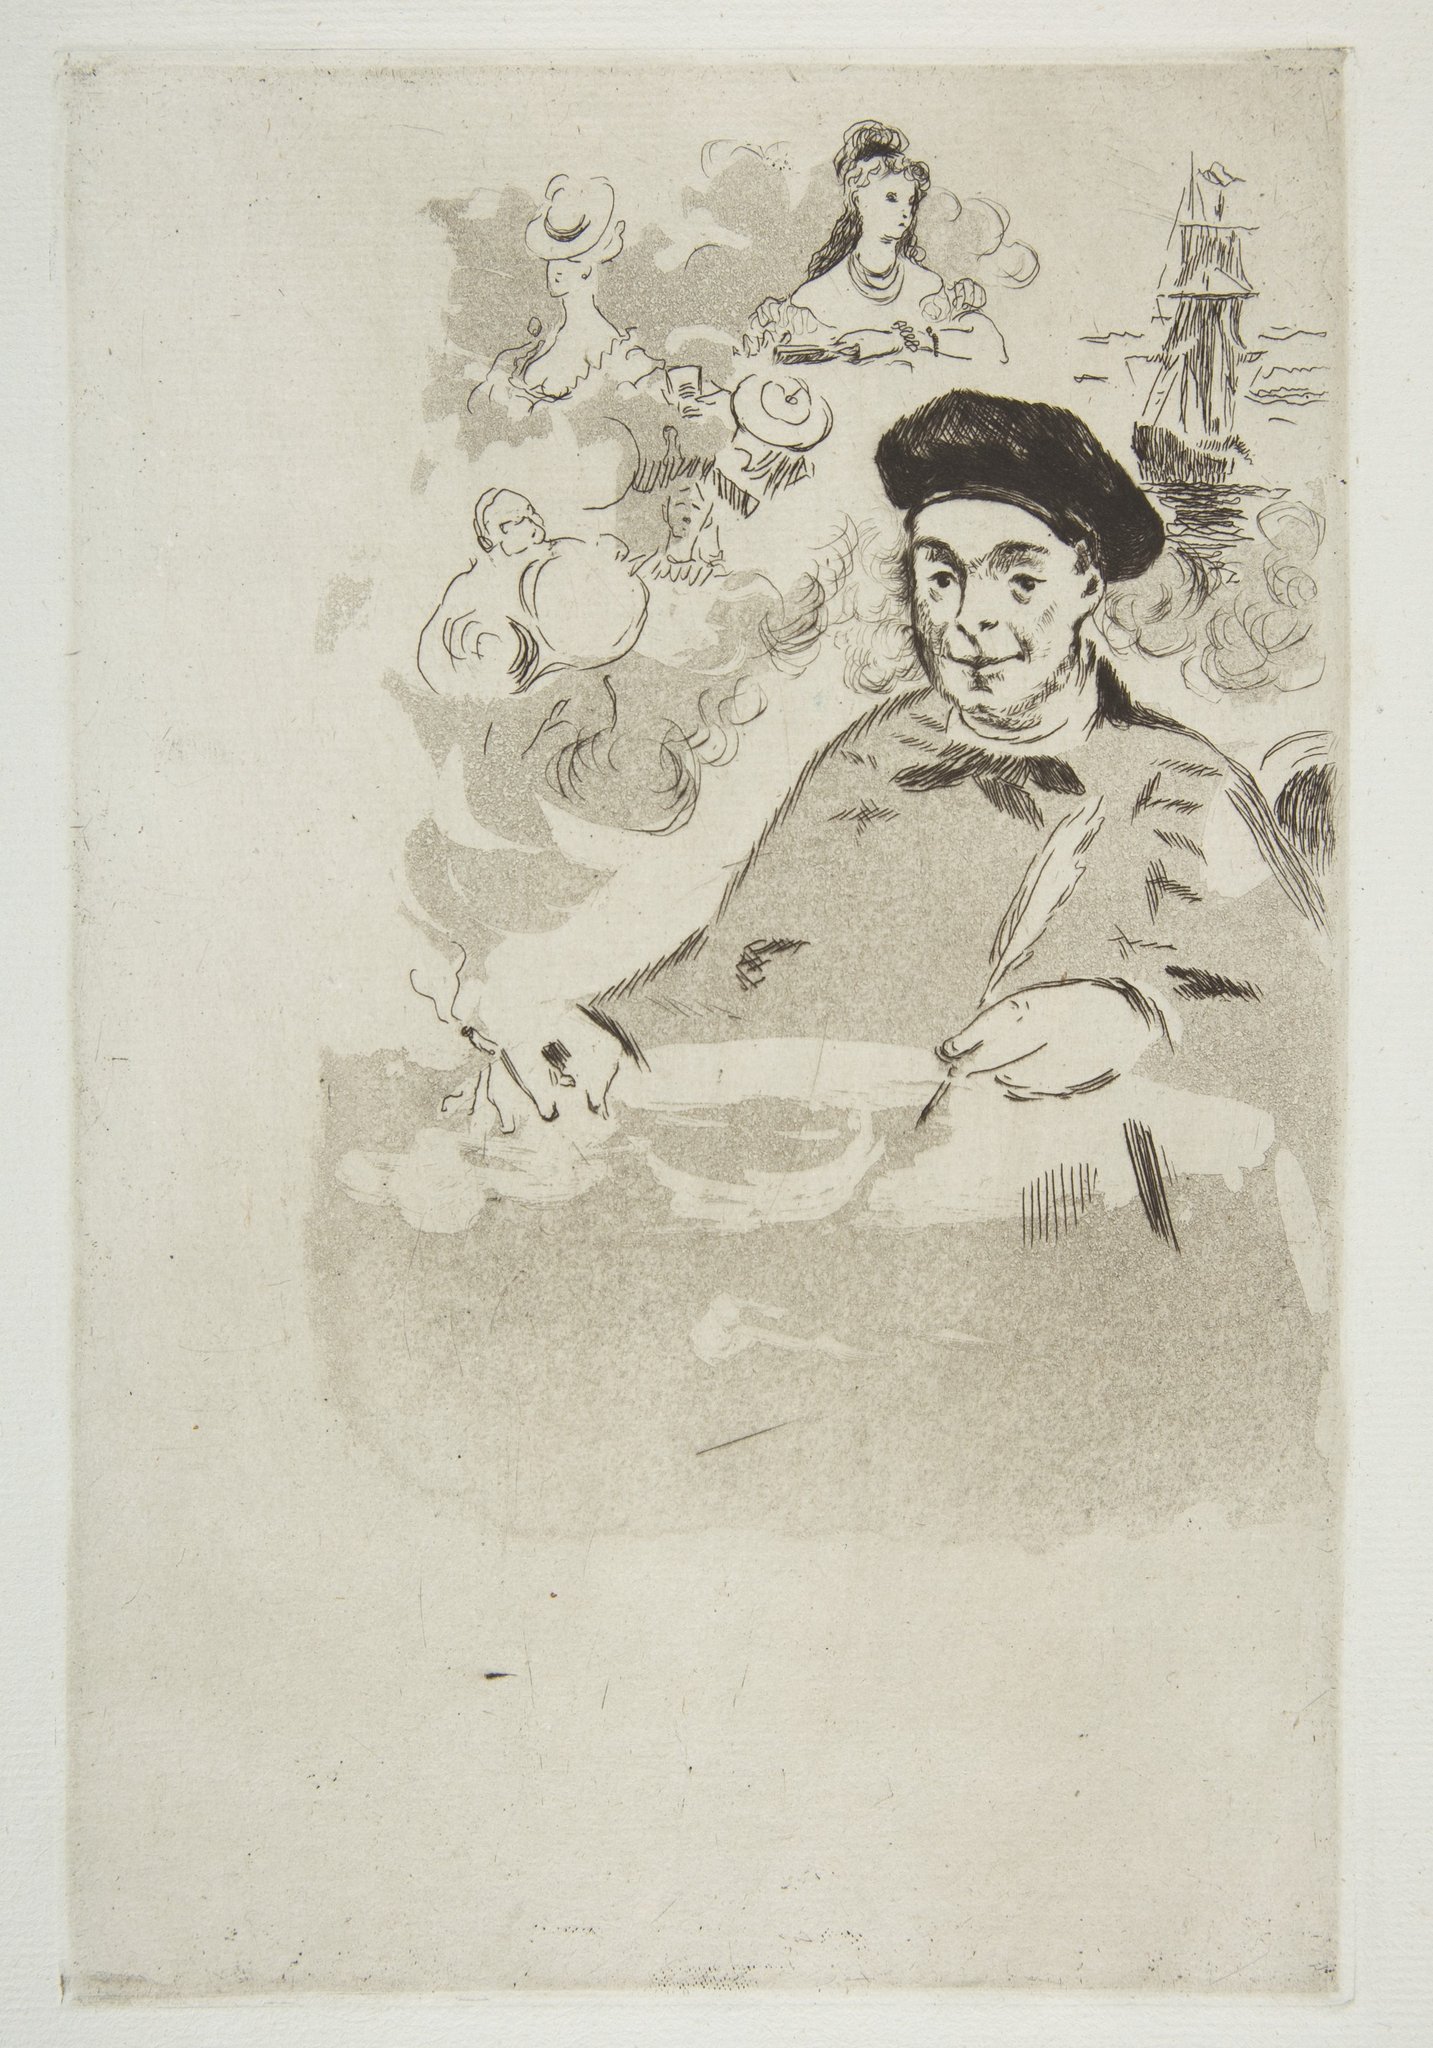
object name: print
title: Frontispiece for an edition of "Les Ballades" by Théodore de Banville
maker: édouard manet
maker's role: artist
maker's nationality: french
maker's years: 1832-1883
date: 1874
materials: paper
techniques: aquatint, etching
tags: men,women,writing,ships